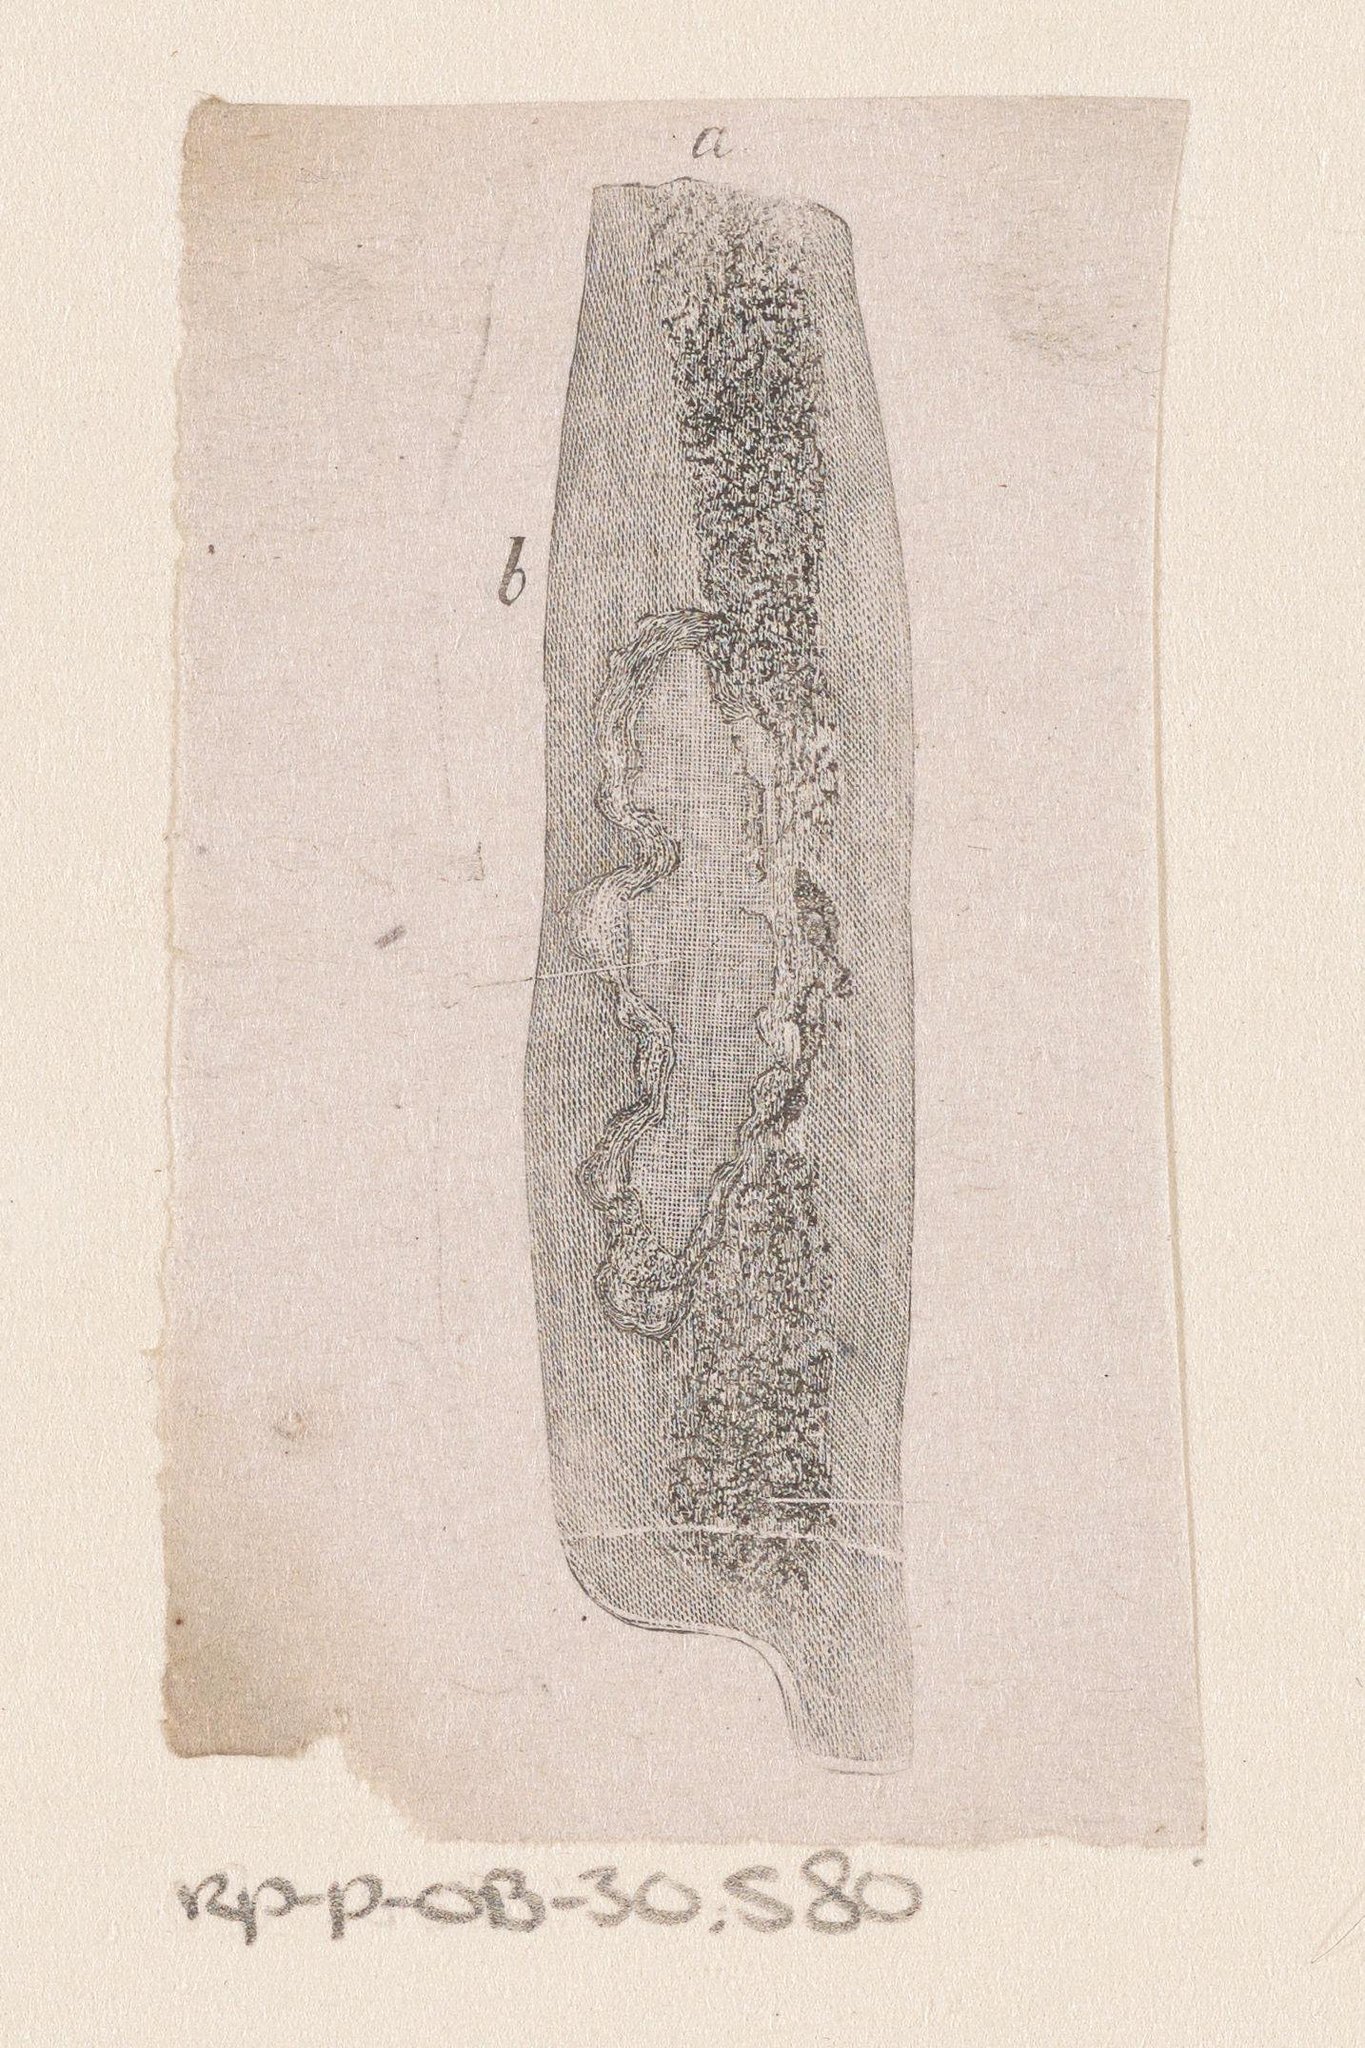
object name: print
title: Onderdeel van het menselijk lichaam met een afwijking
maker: isaac weissenbruch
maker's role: print maker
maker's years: 1826-1912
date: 1836-1912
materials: paper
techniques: engraving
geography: netherlands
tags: anatomy (non-medical), diseases